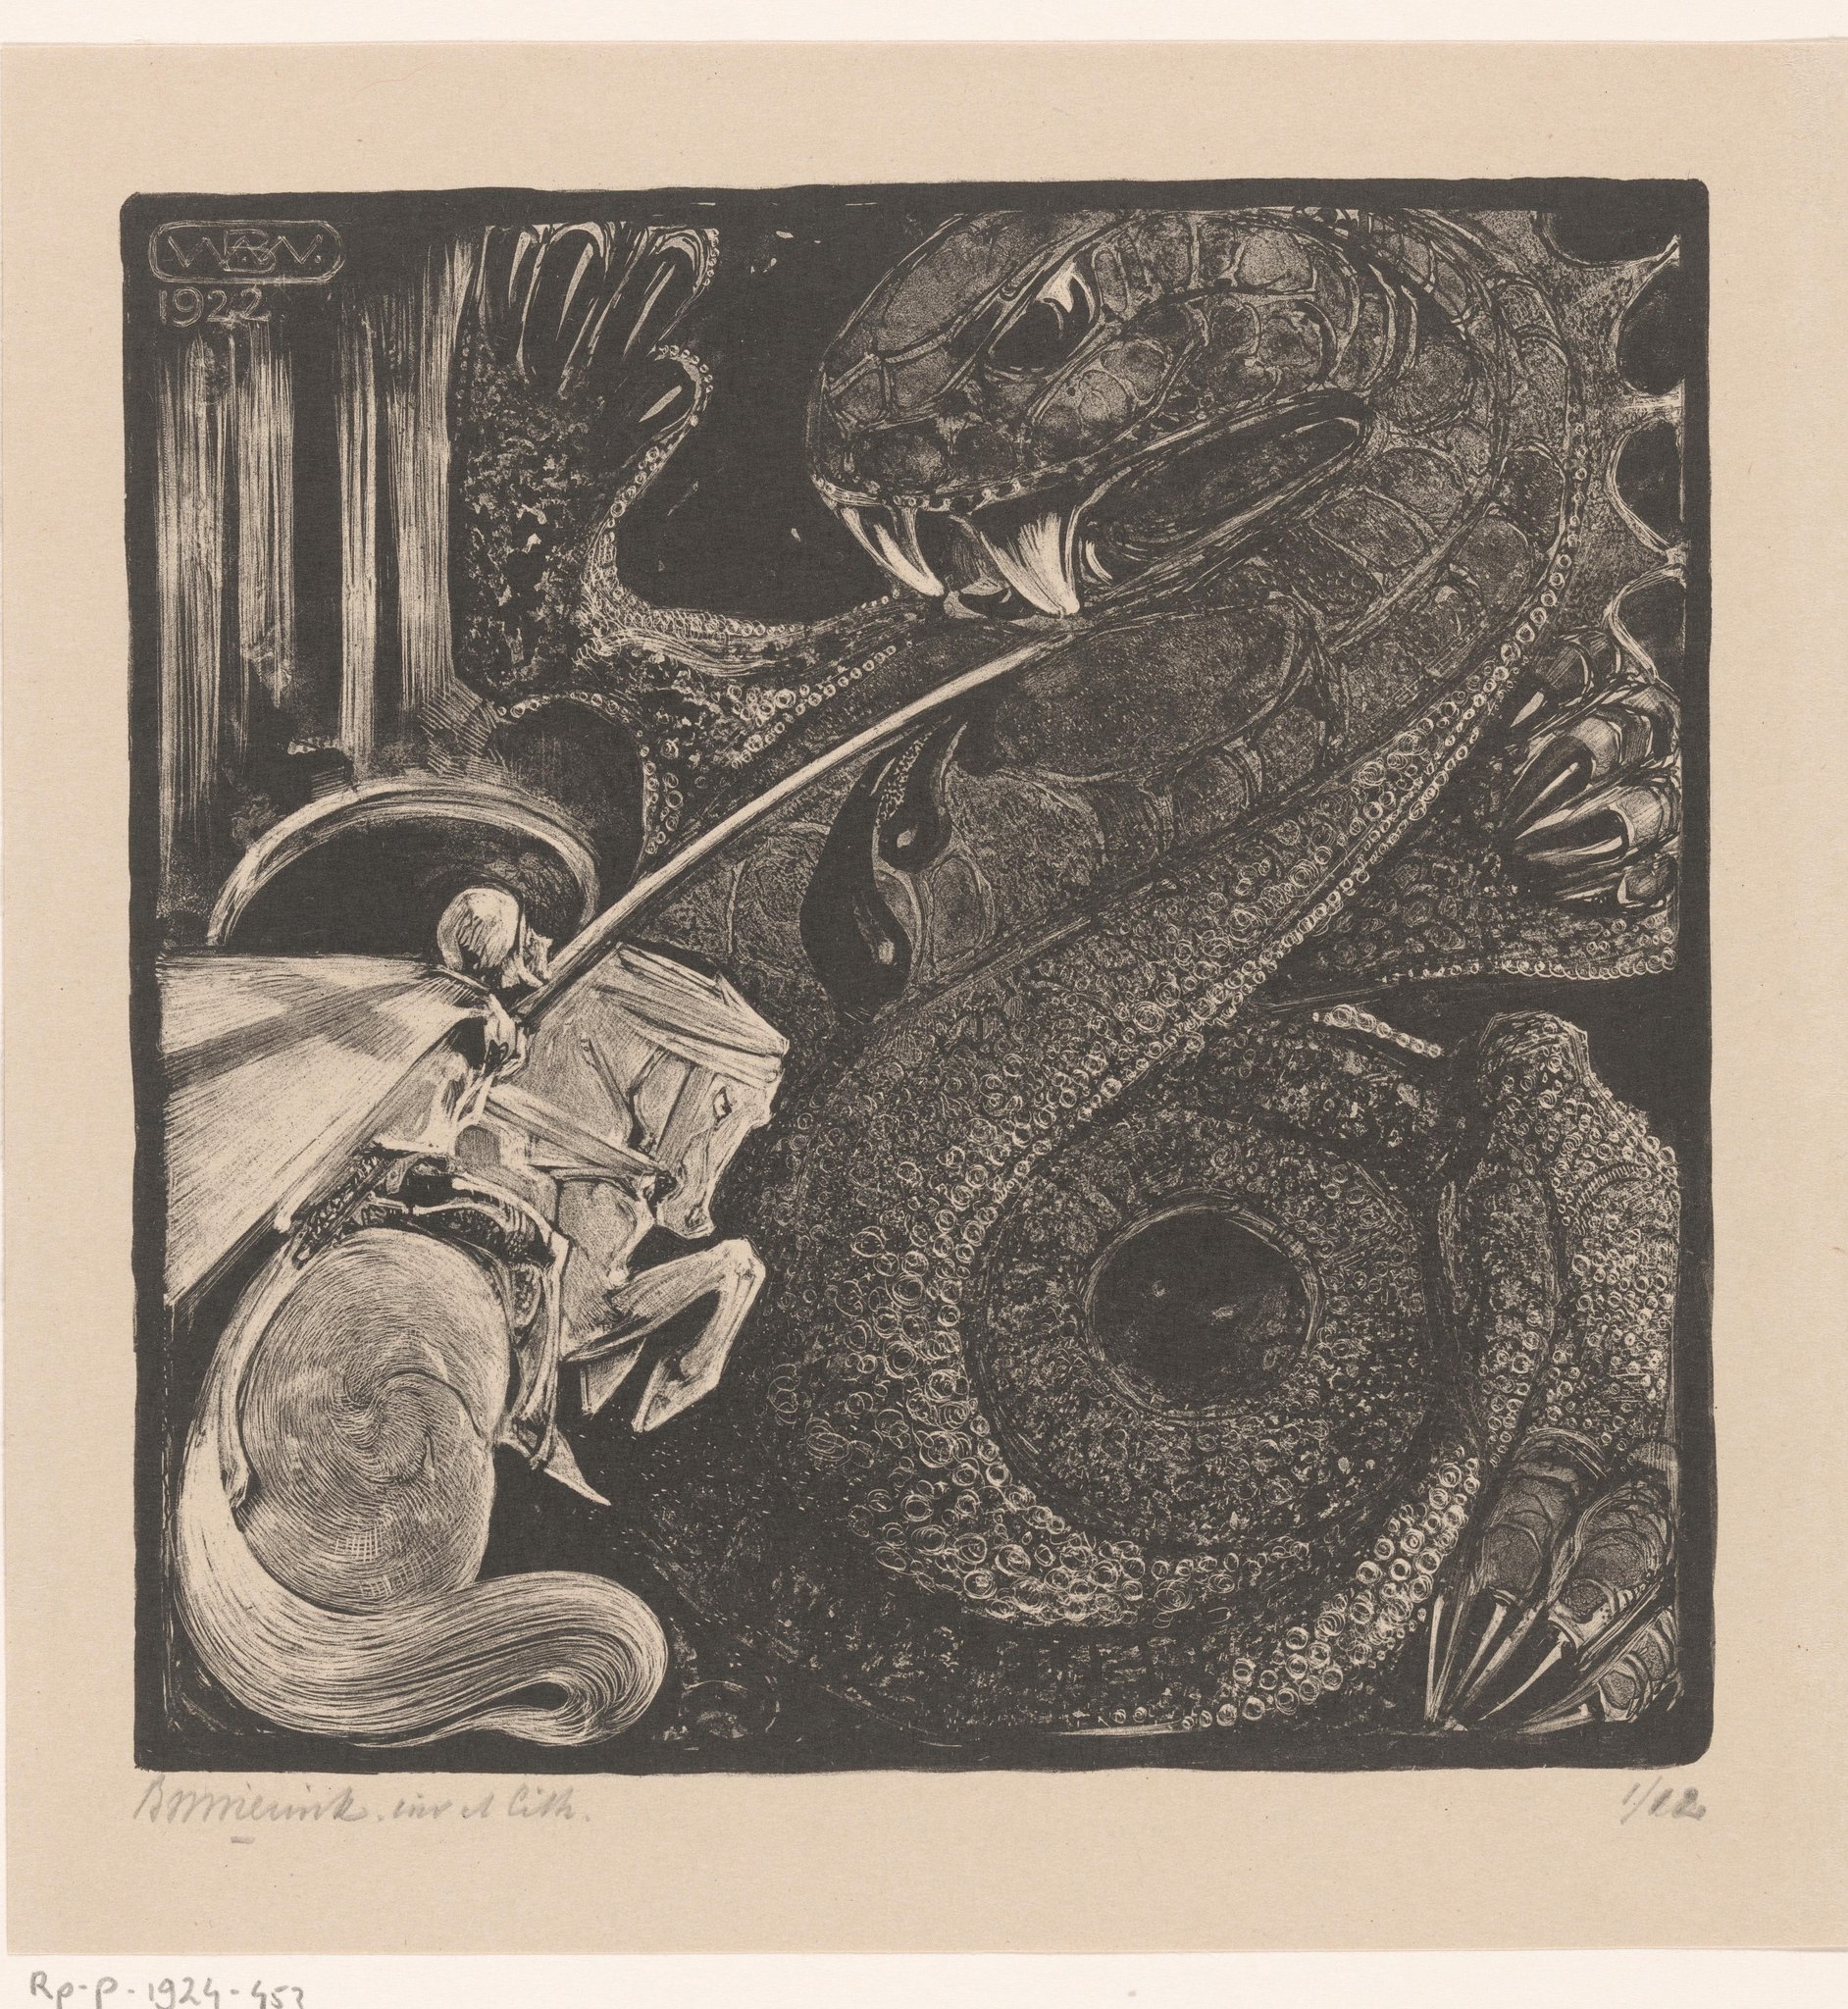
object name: print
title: St. Joris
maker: bernard willem wierink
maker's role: draughtsman, print maker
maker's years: 1856-1939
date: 1922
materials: paper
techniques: lithograph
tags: the warrior martyr george (georgius); possible attributes: banner (red cross on white field), (red) cross, dragon, (white) horse, broken lance, shield (with cross), sword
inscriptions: collector's mark: Lugt 2228